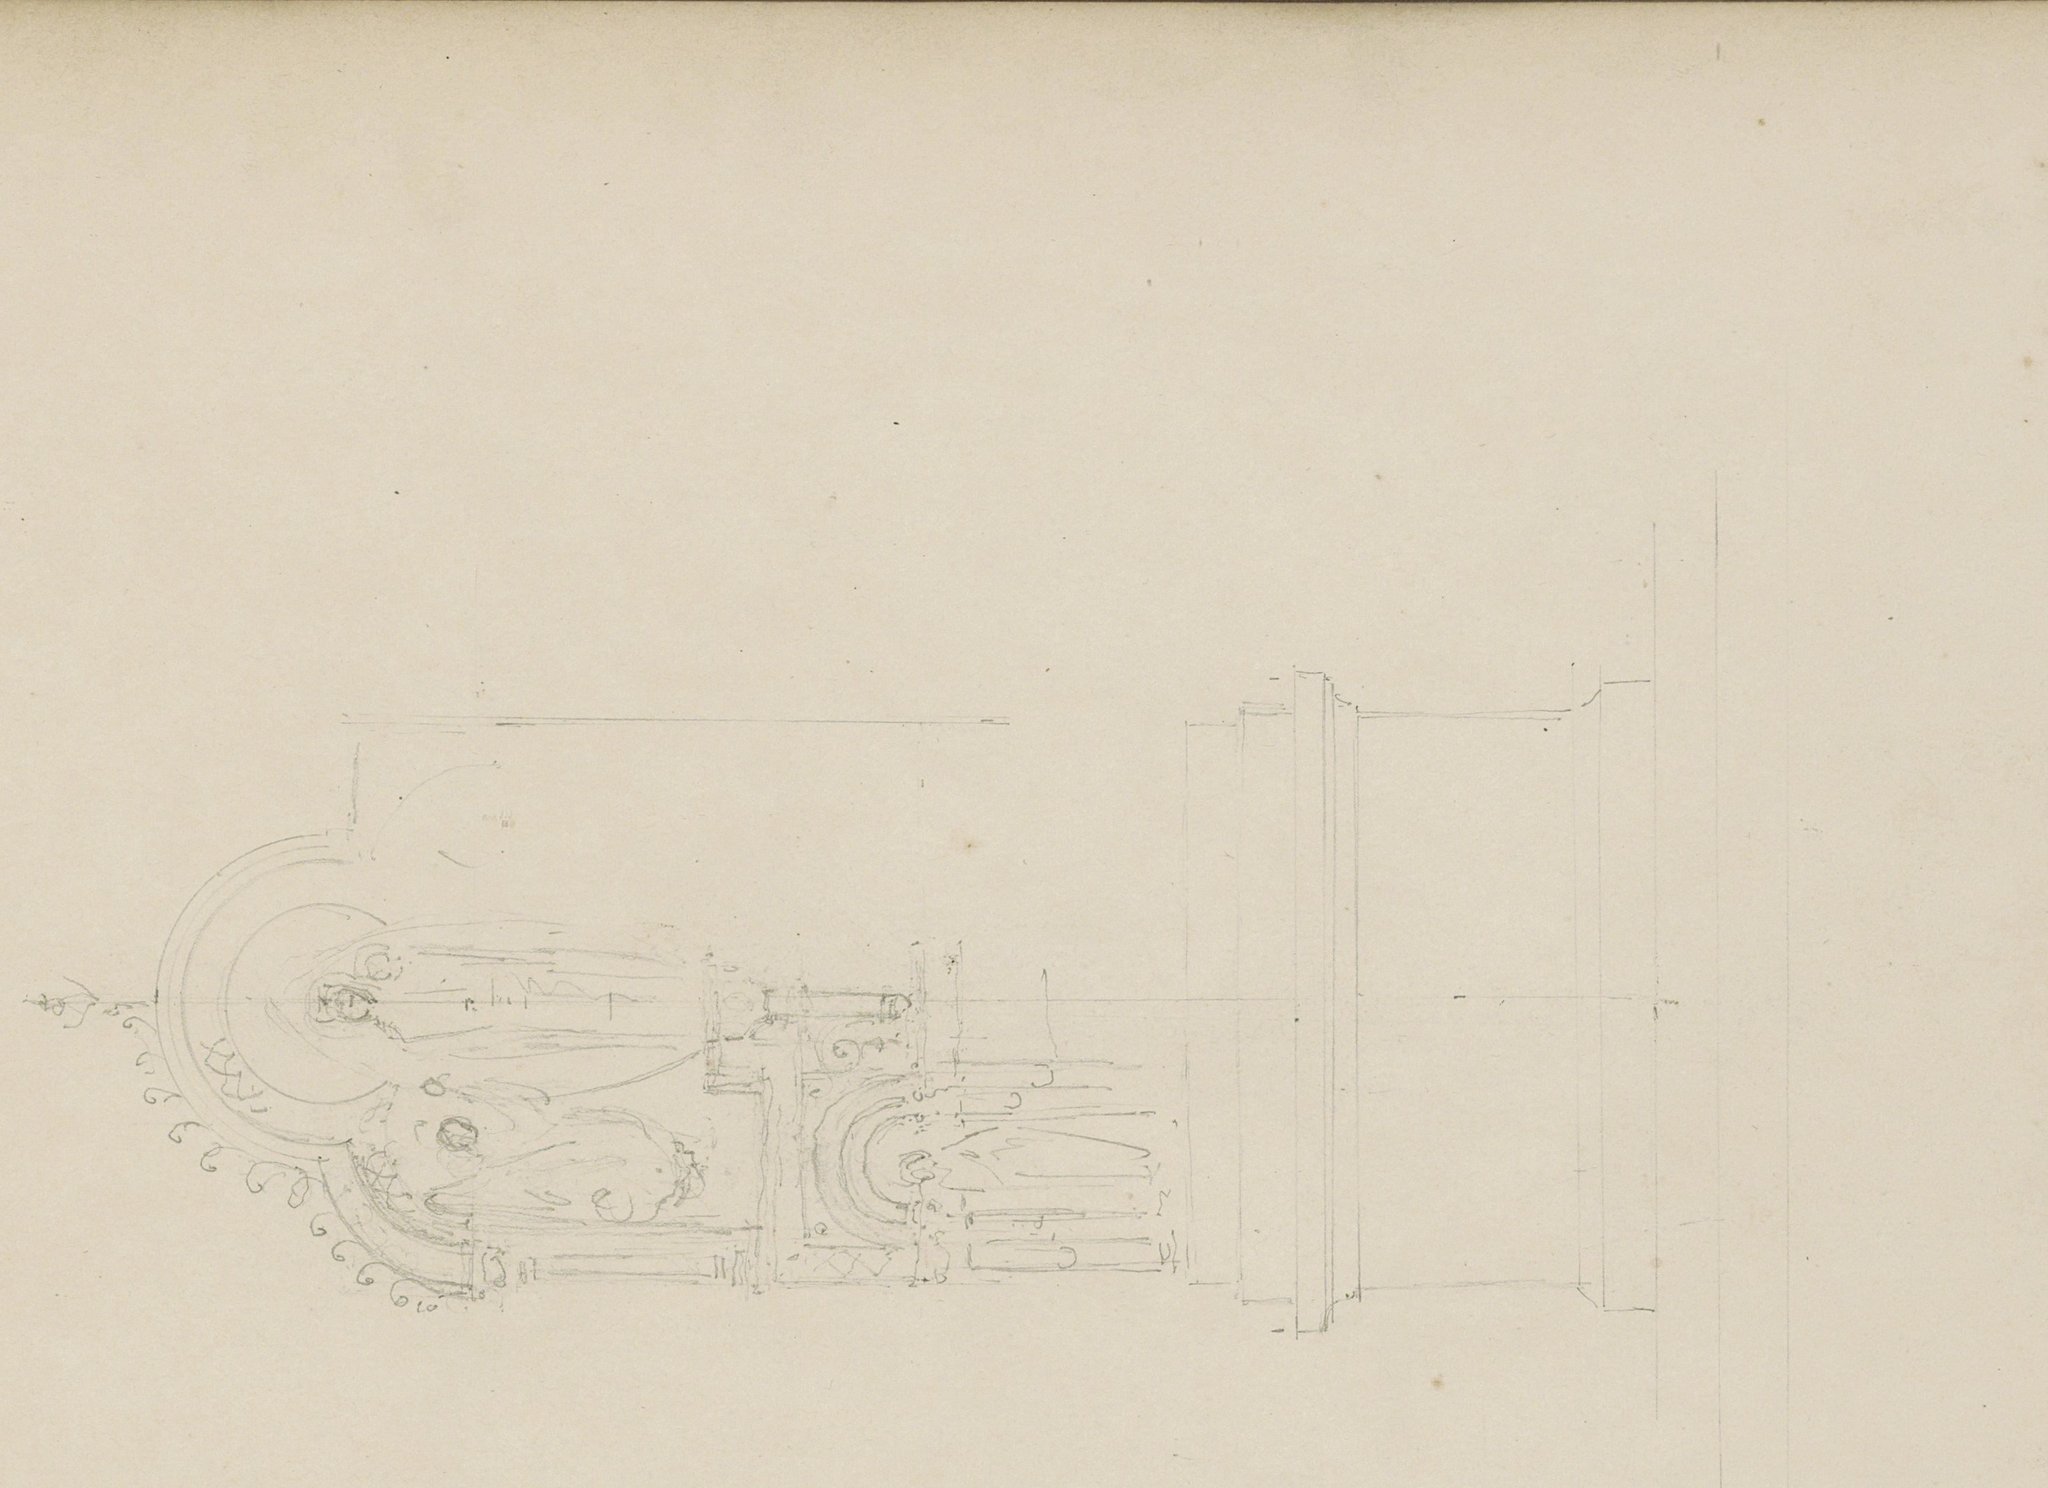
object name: sketchbook leaf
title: Altaar, Wildenrath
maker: pierre joseph hubert cuypers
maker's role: draughtsman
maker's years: 1827-1921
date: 1801-1859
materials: paper, pencil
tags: altar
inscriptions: date and inscription: ‘-January 1859-/ Wildenrath’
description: Titel gebaseerd op inhoudsopgave door Cuypers op blad 77 recto. Tussen blad 45 en 46 zit een fragment van een papier met daarop in bruine pen geschreven '[...]oude/ [...]schilacte' en twee stempels, één met de letters 'PD', de ander met 'GAND/ 16/ NUC/ 63/ 2s'.